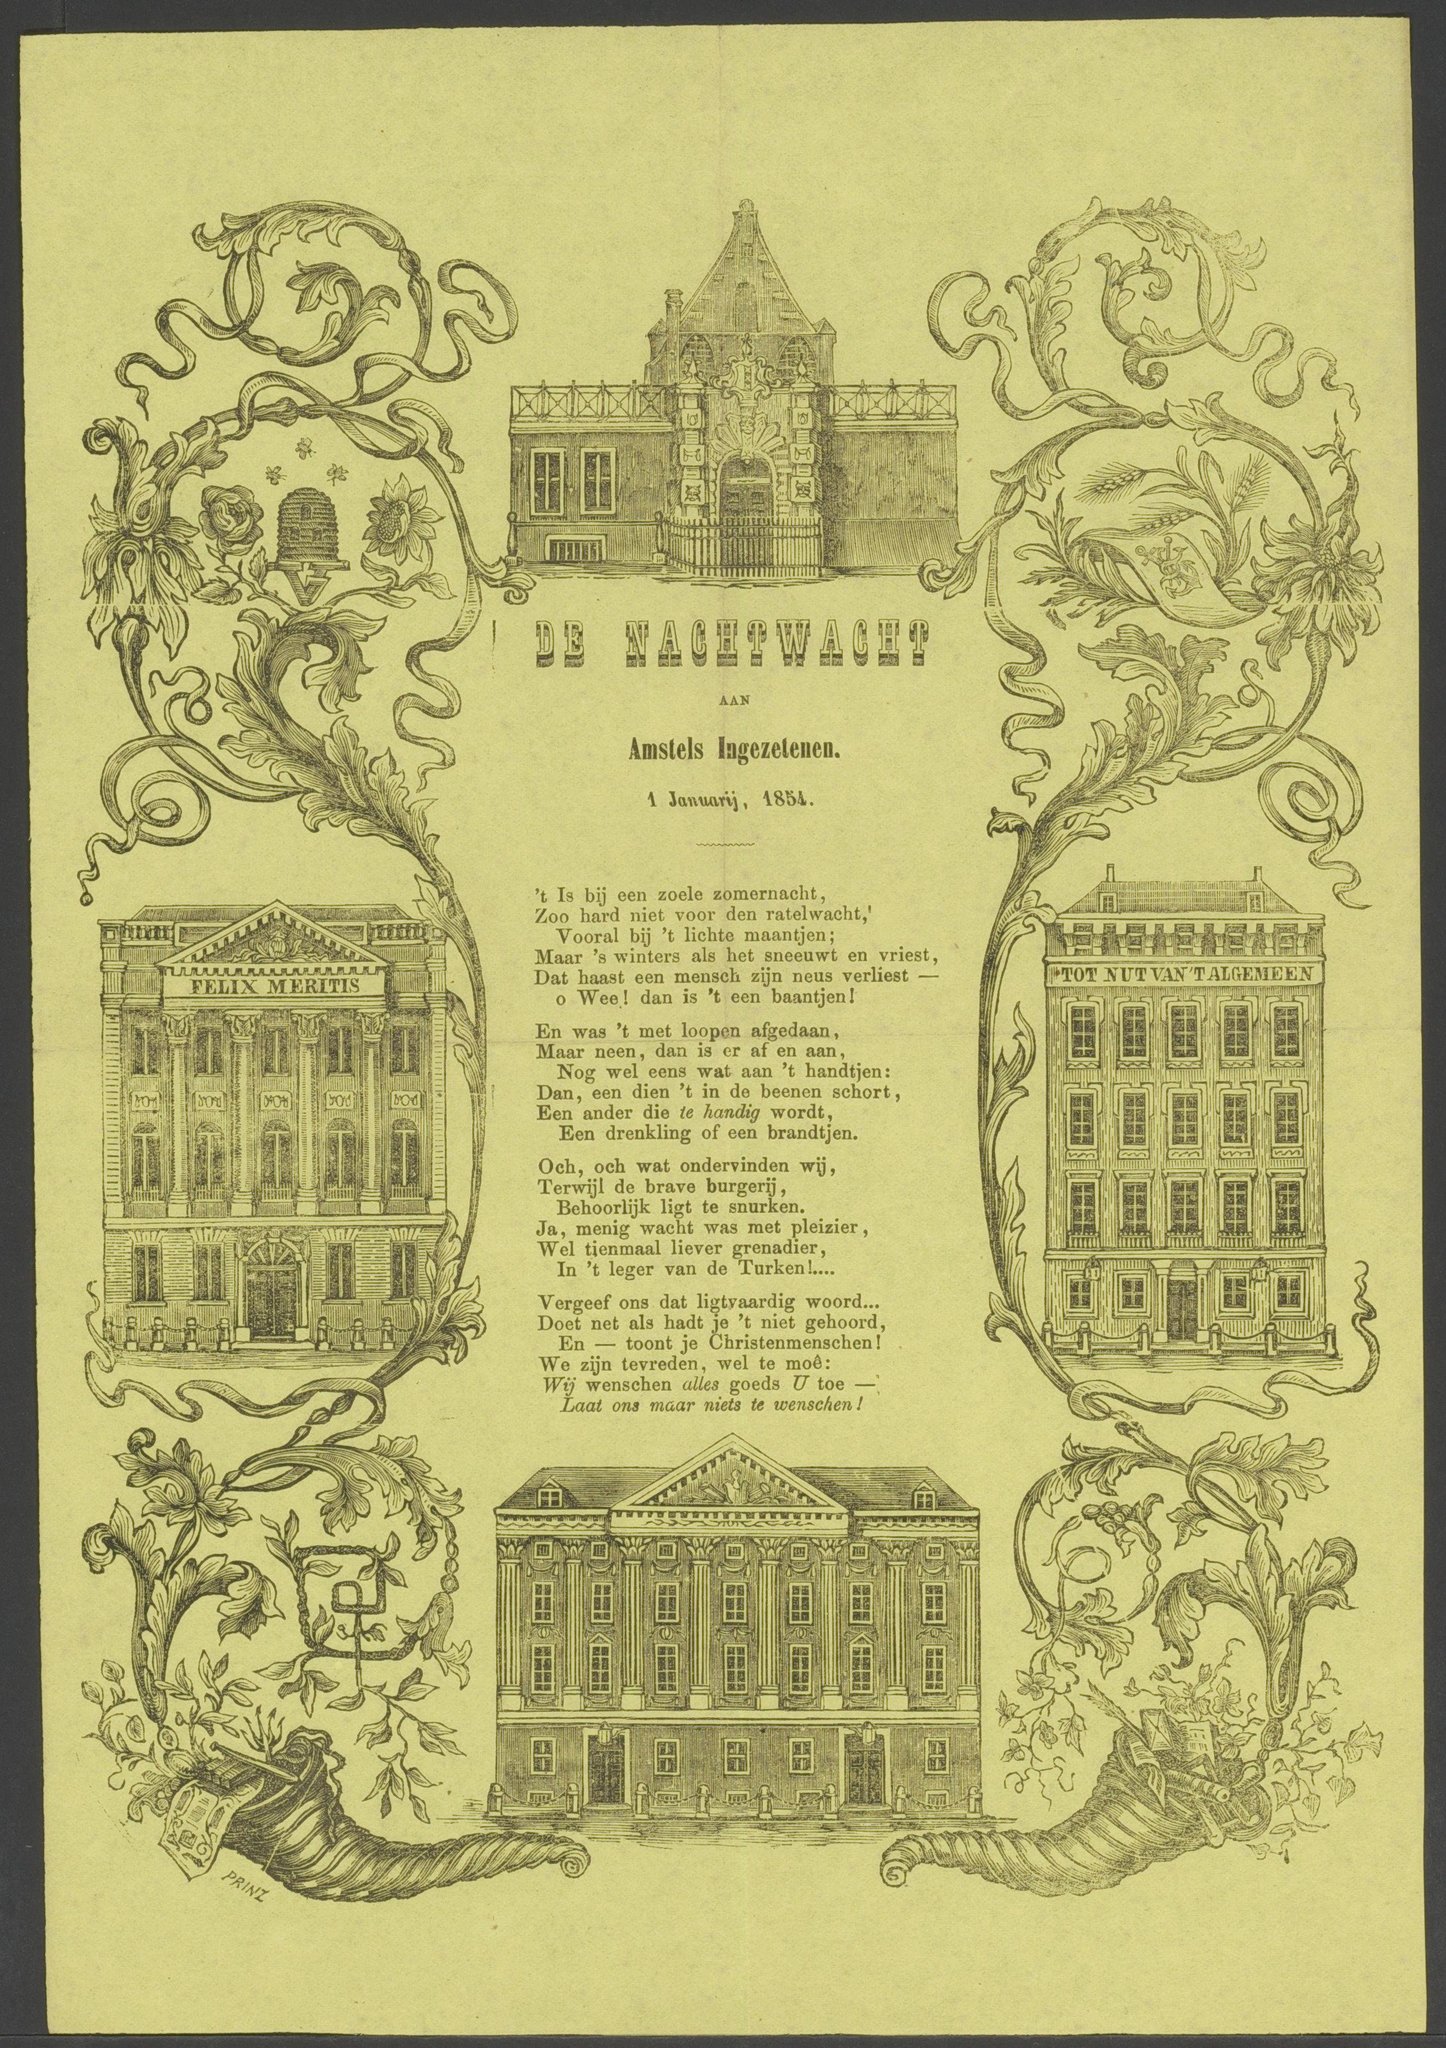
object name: new year card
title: De Nachtwacht aan Amstels Ingezetenen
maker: friedrich robert prinz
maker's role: print maker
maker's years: 1820-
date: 1853-1854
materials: paper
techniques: letterpress printing, engraving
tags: night patrol, civic architecture; edifices; dwellings, edifice, e.g.: public building, department store, amsterdam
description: Nieuwjaarswens van de Amsterdamse nachtwacht (ratelwacht) voor het jaar 1854. Centraal een gedicht in vier verzen, omringd door gebouwen tussen bladranken en hoornen van overvloed: Agnietenkapel, Felix Meritis, het gebouw van de Maatschappij tot Nut van 't Algemeen en het Trippenhuis. Onderwerpsrubrieken binnen de Atlas Zeden en Gewoonten: Zeden en gewoonten in engeren zin, Volksleven, Volksbladen, Nieuwjaars- en Kerstwenschen, Amsterdam.